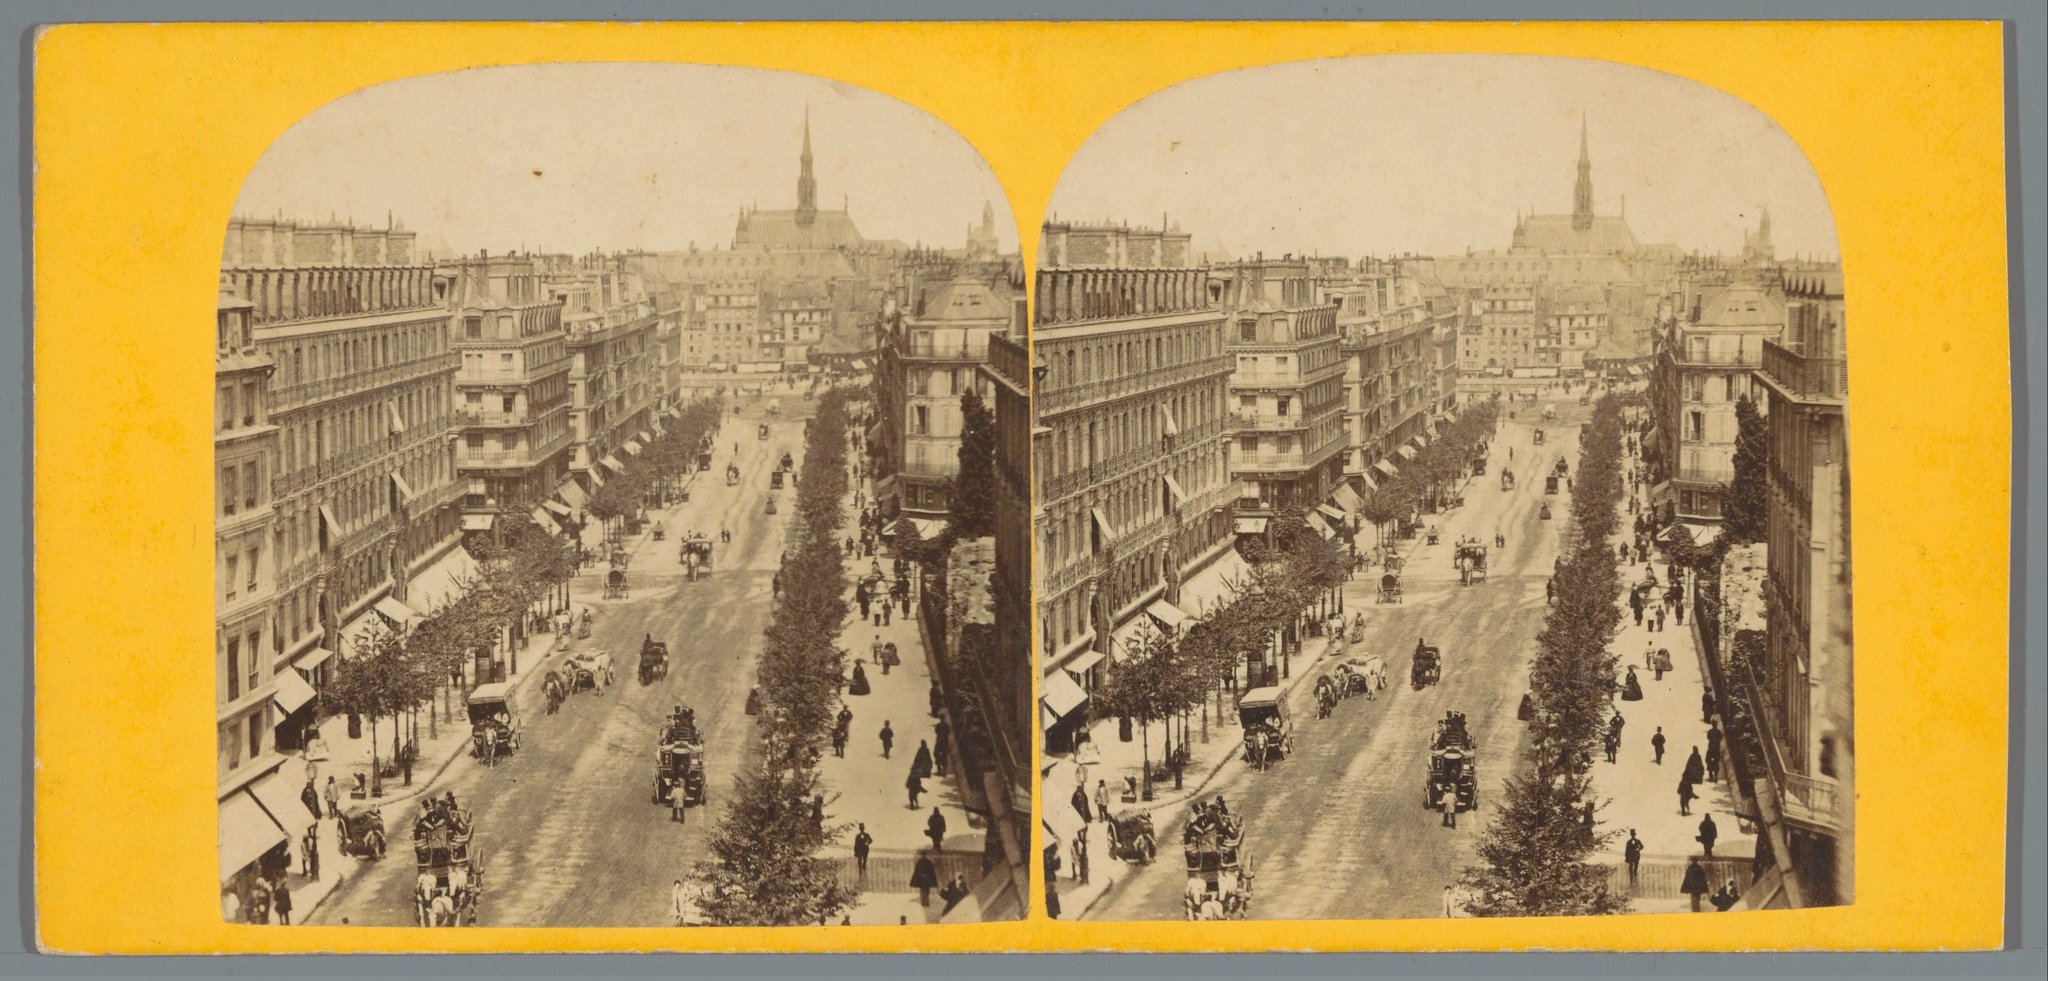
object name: stereograph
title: Paris instantanné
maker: Anonymous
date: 1850-1880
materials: cardboard, photographic support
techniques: albumen print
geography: paris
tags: church (exterior), street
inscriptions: inscription: ‘Jahr[...] no. 18.’, number: ‘No. 48’